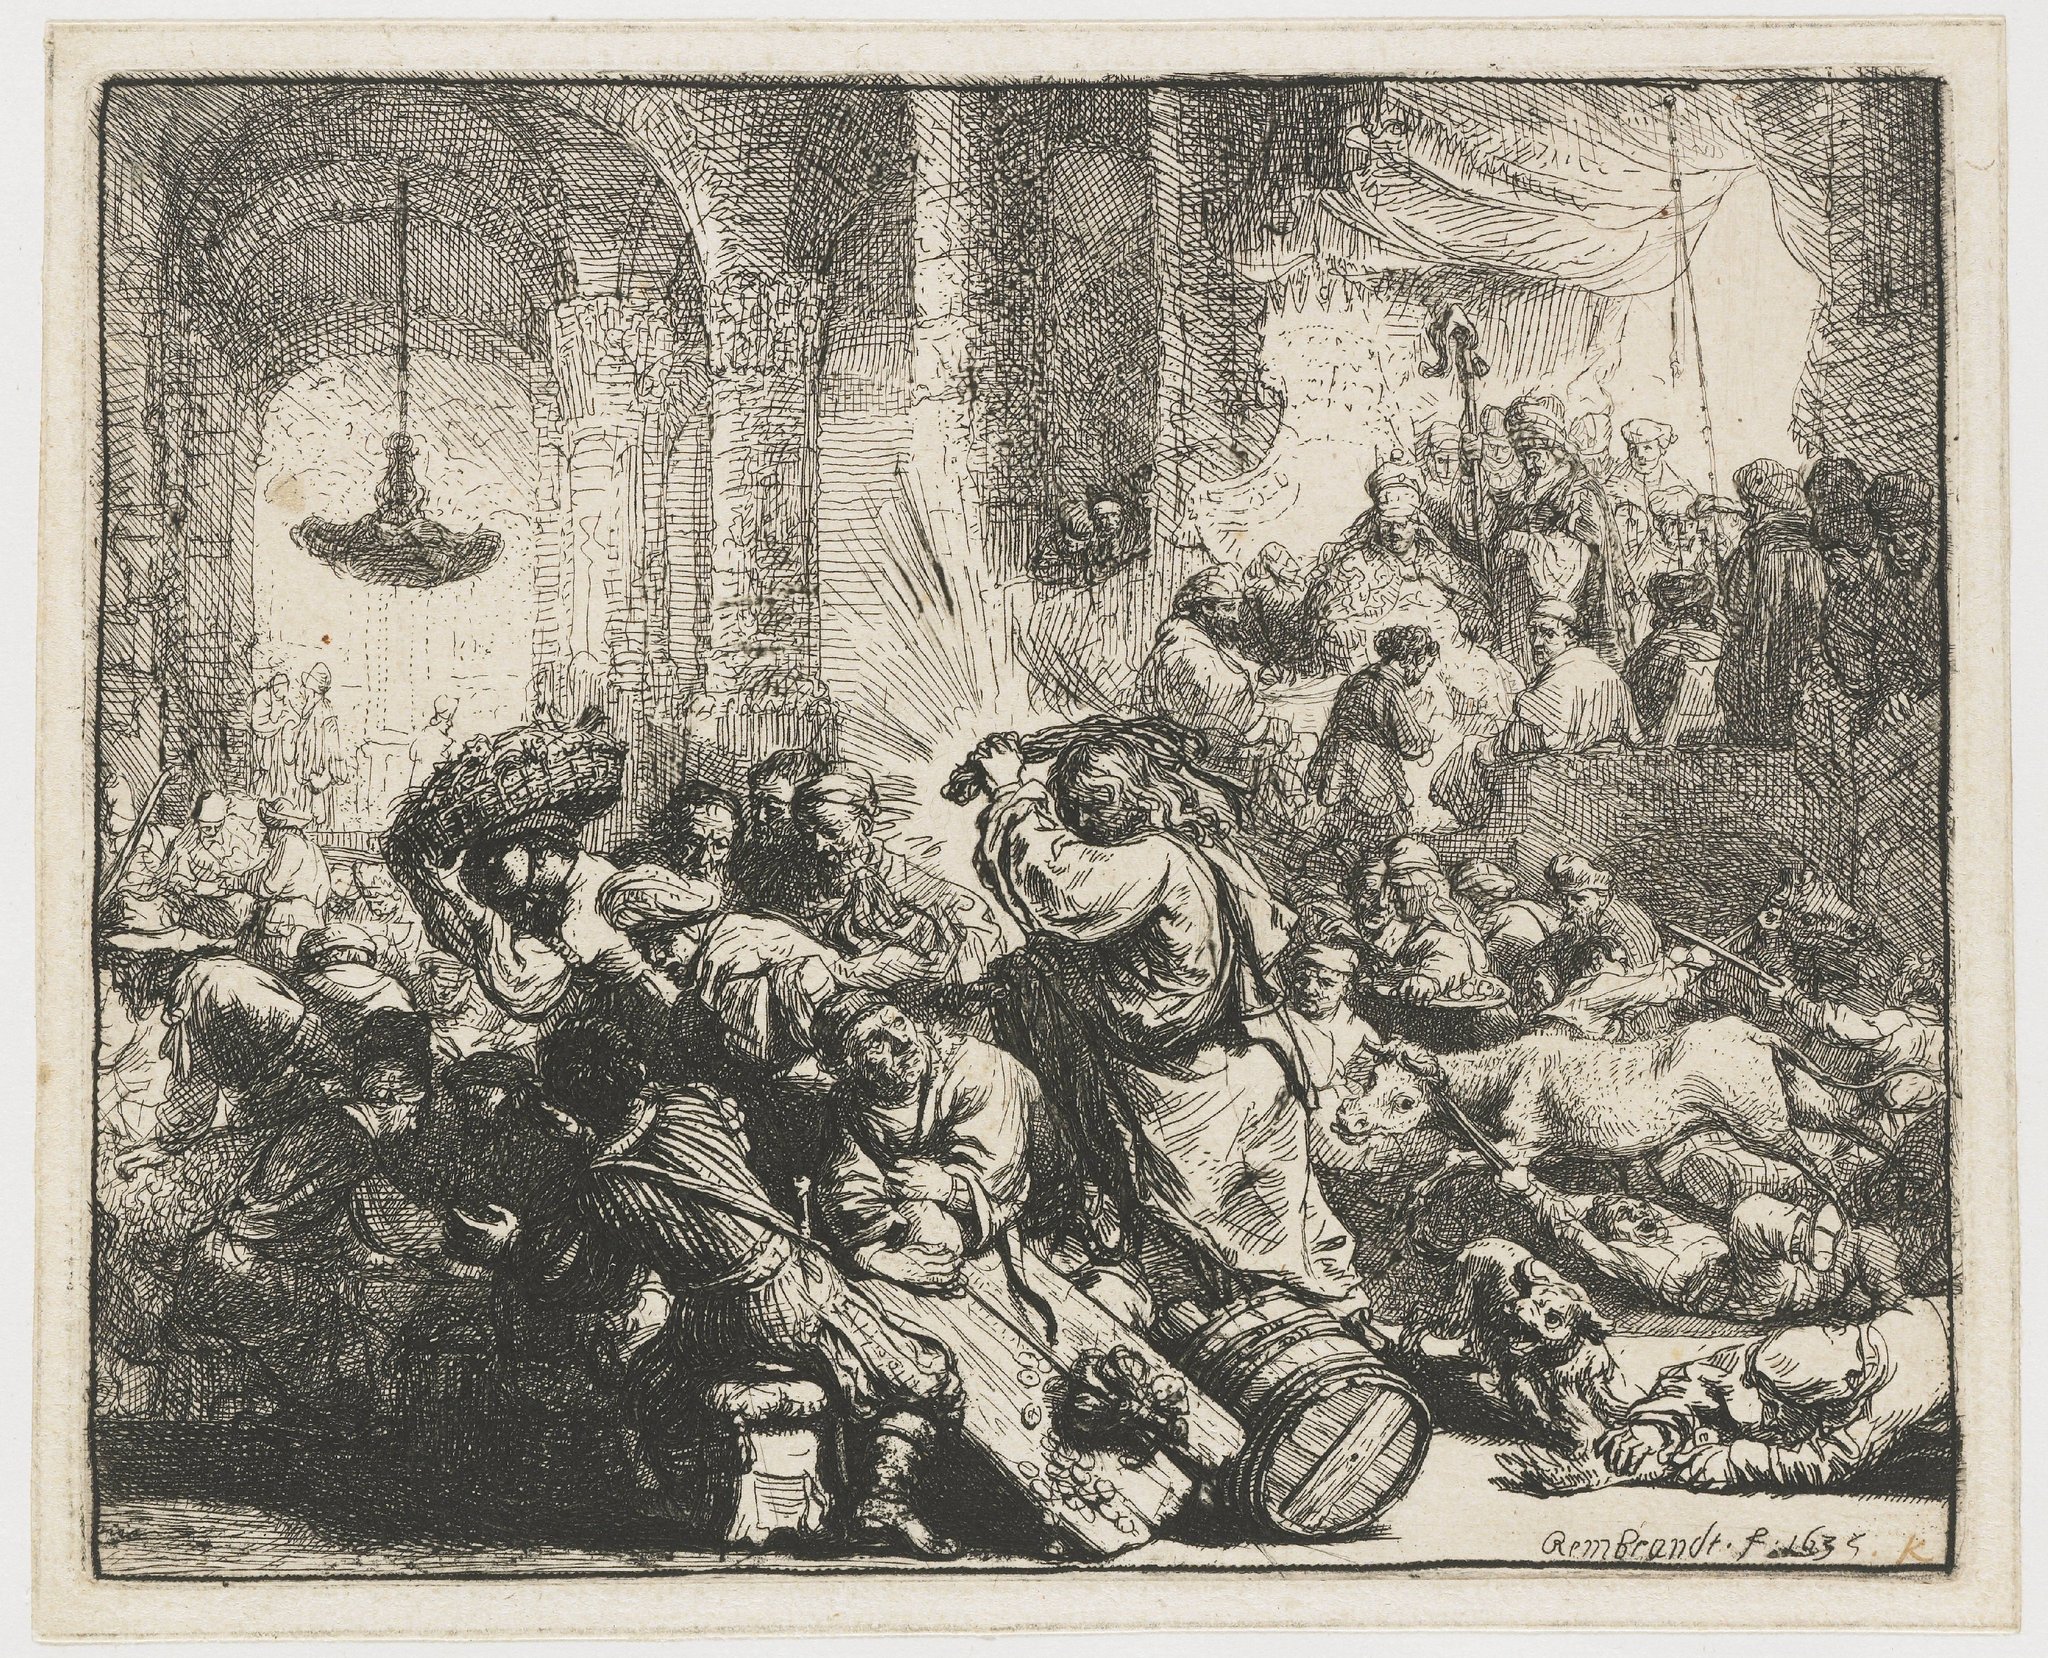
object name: print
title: Christ driving the money changers from the temple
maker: rembrandt van rijn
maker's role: draughtsman, painter, print maker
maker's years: 1606-1669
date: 1635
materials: paper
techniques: etching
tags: purification of the temple ('first' and 'second'): christ driving the money-changers from the temple with a whip (matthew 21:12-13; mark 11:15-17; luke 19:45-46; john 12:12-19)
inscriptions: inscription: ‘12 St’, collector's mark: Lugt 240